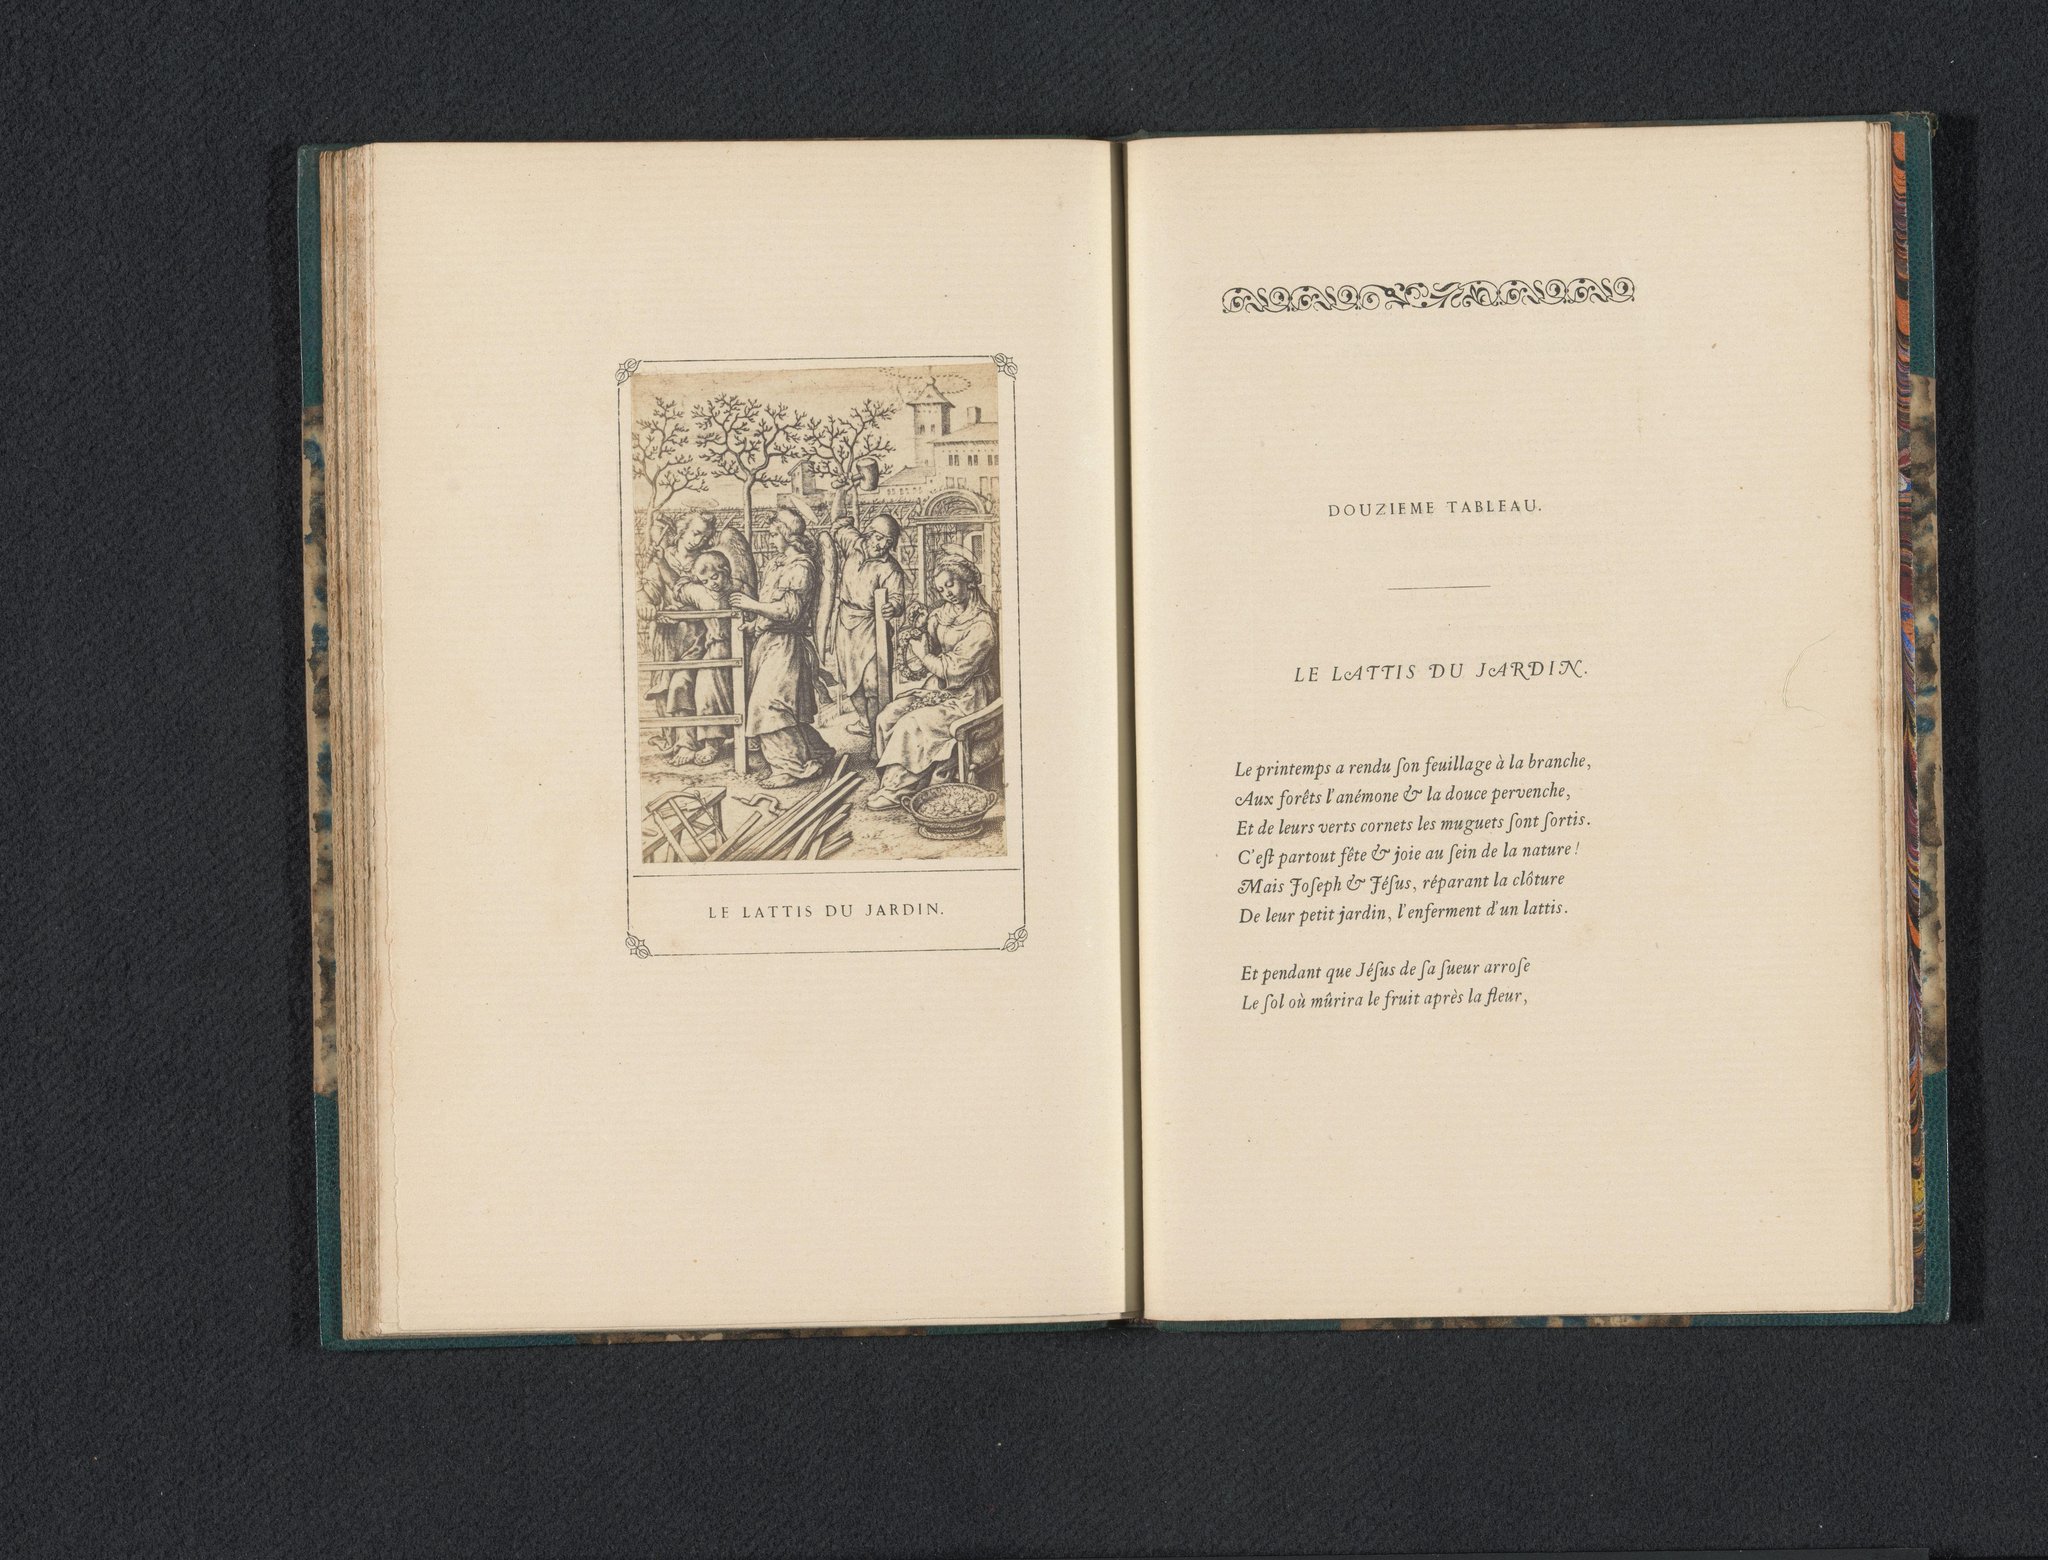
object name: photograph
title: Fotoreproductie van Le lattis du jardin door Edmond Fierlants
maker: edmond fierlants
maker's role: fotograaf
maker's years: 1819-1869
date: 1855-1860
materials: photographic support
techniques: albumen print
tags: garden, angels